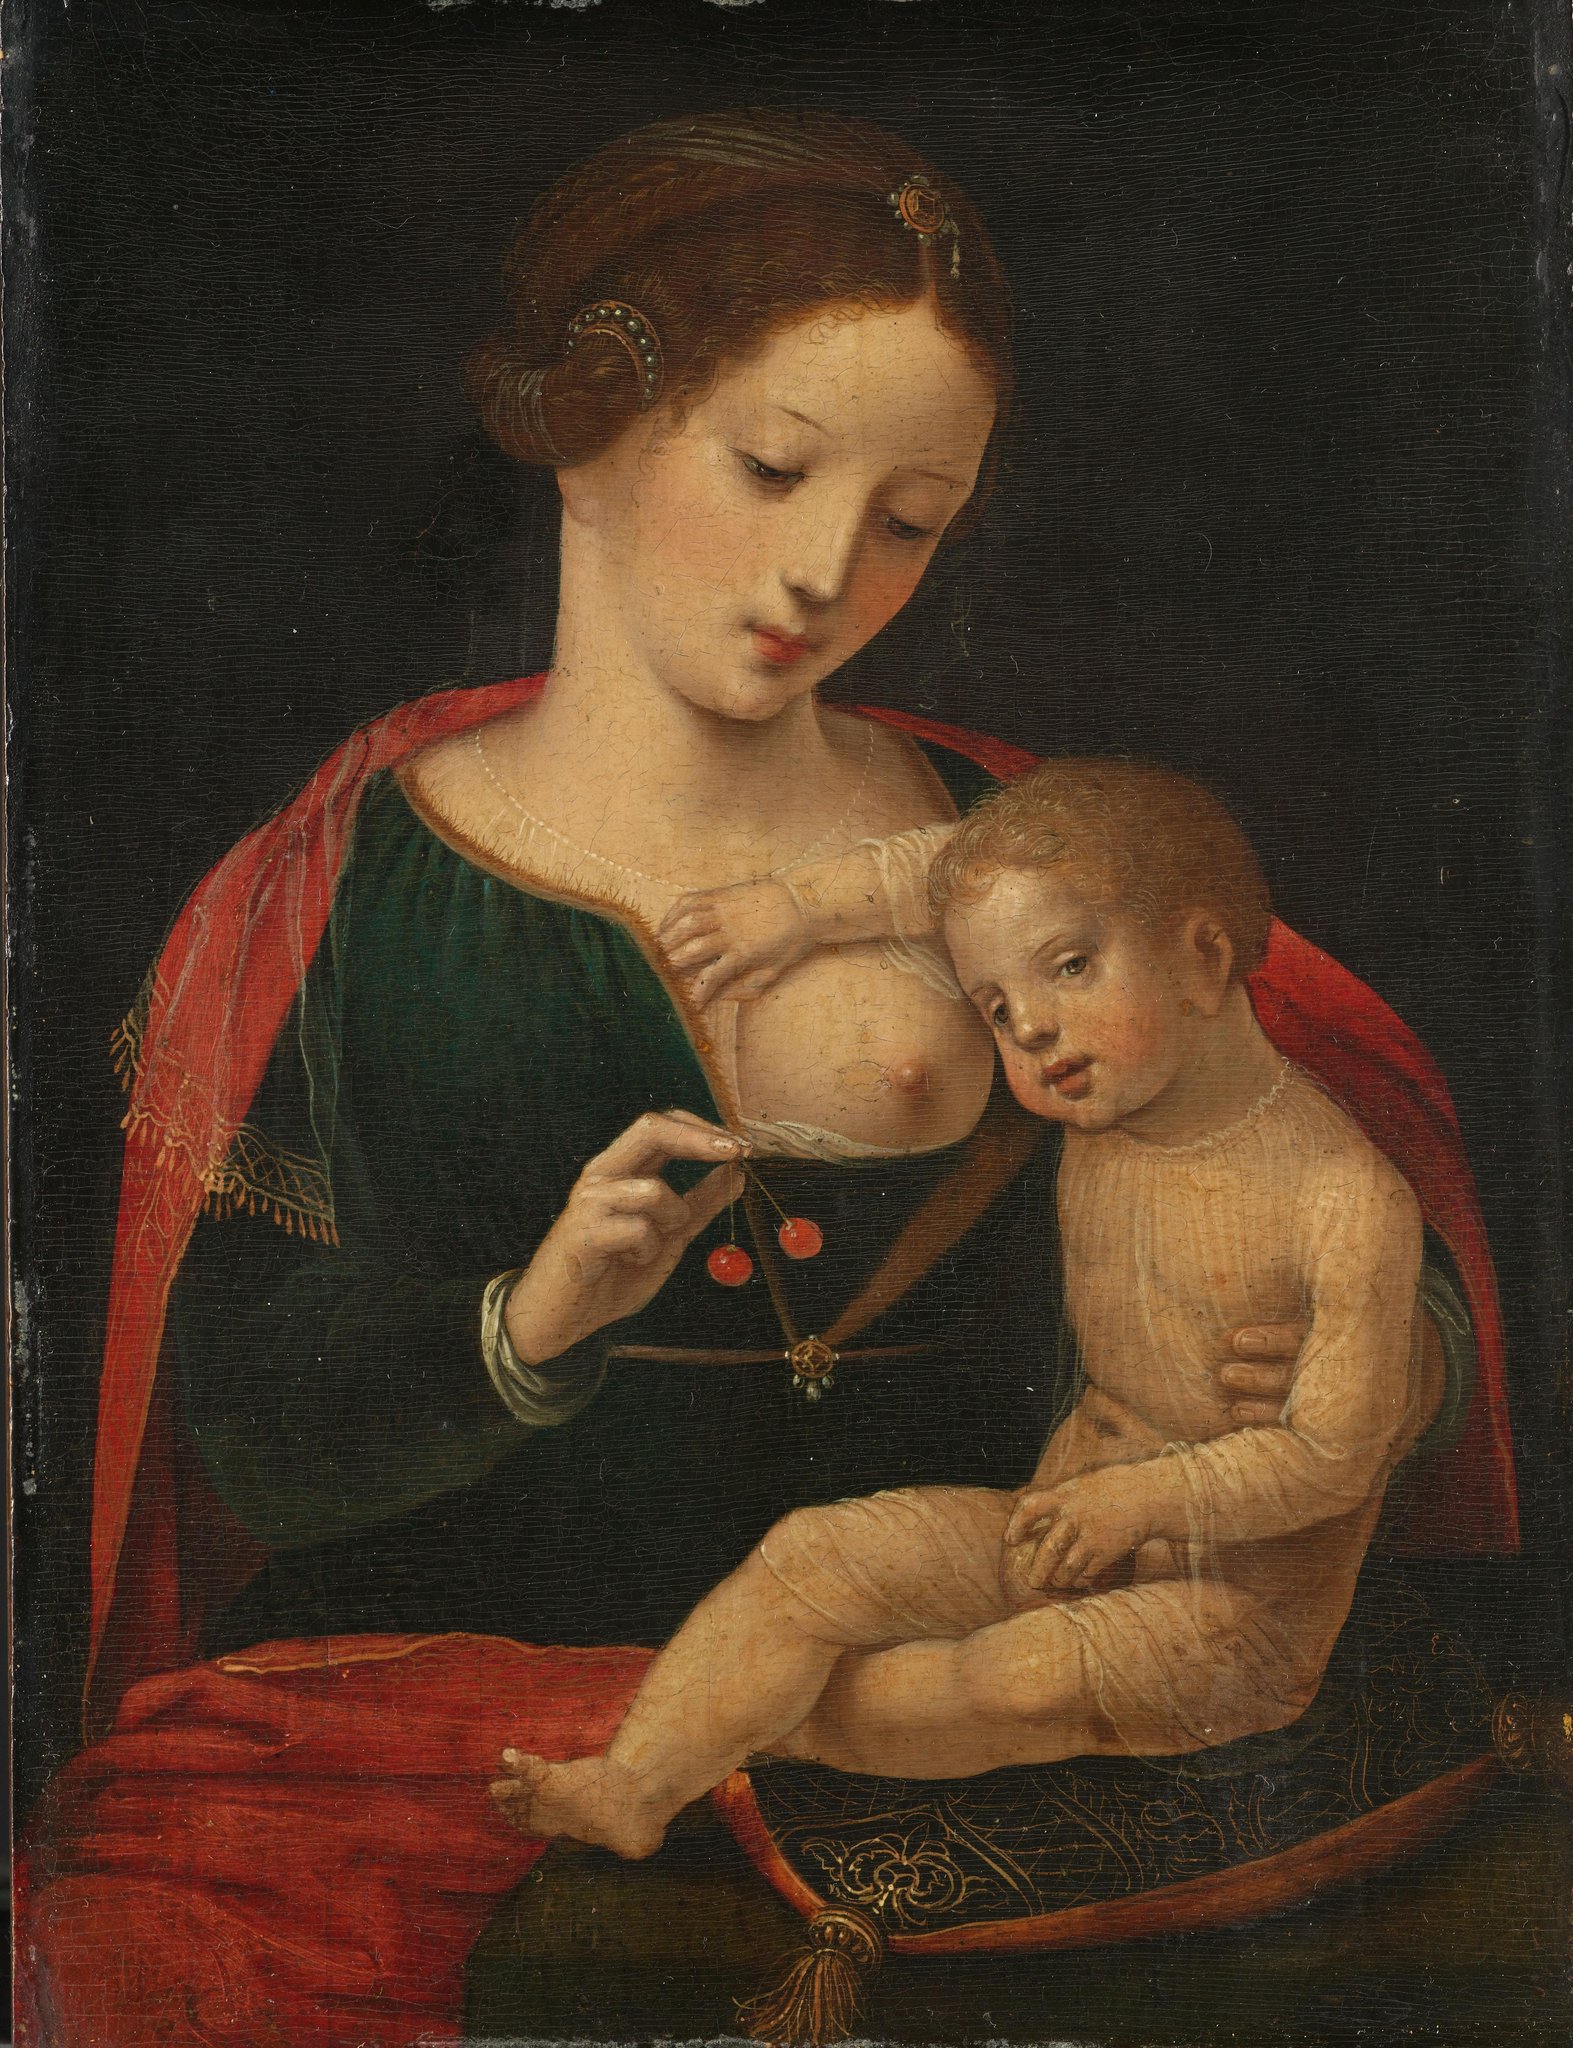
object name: painting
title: Virgin and Child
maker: meester van de vrouwelijke halffiguren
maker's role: painter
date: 1520-1540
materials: oil, panel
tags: 'ablactatio'; christ not drinking, mary's breast bare ~ madonna-representations, mary sitting or enthroned, the christ-child in front of her, sitting in her lap (or in front of her bosom)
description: Maria met kind. Halffiguur van Maria met het Christuskind voor zich zittend op een kussen. Het kind legt zijn arm rond de ontblote linkerborst, Maria houdt een takje kersen in haar hand.